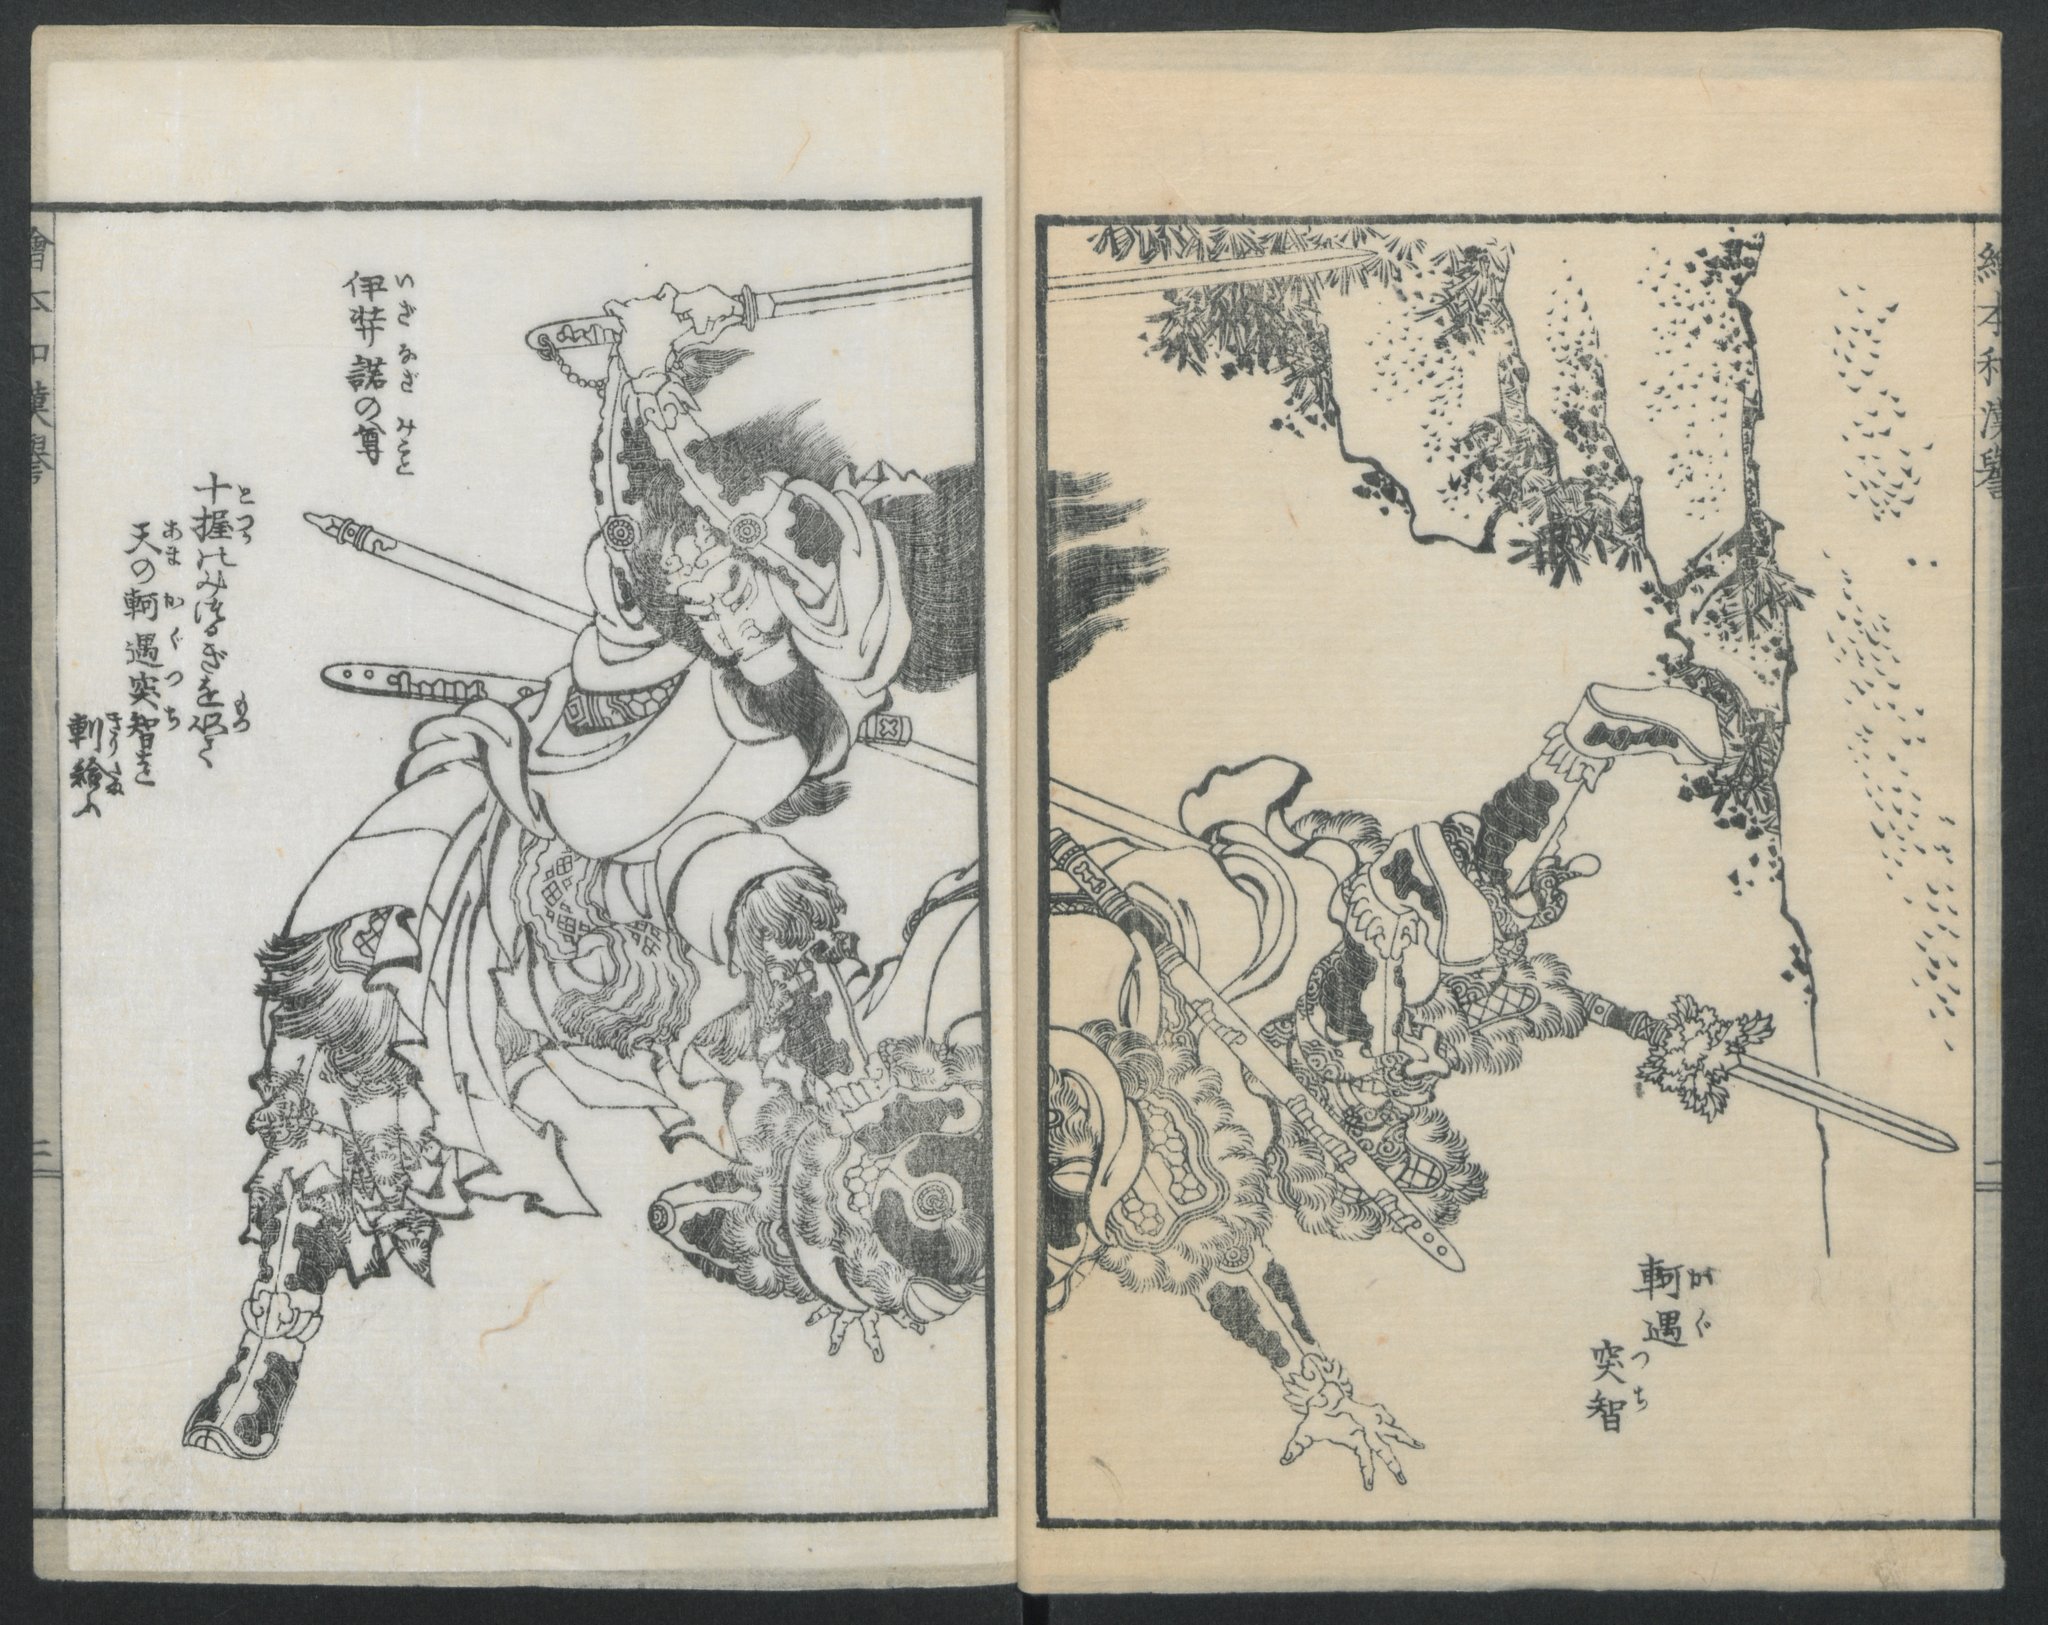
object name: illustrated book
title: Illustrations of Honorable Anecdotes of Japan and China (Ehon wakan no homare) 絵本和漢誉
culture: japanese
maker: katsushika hokusai 葛飾北斎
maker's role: artist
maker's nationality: japanese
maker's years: 1760-1849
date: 1850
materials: ink, paper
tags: swords,men